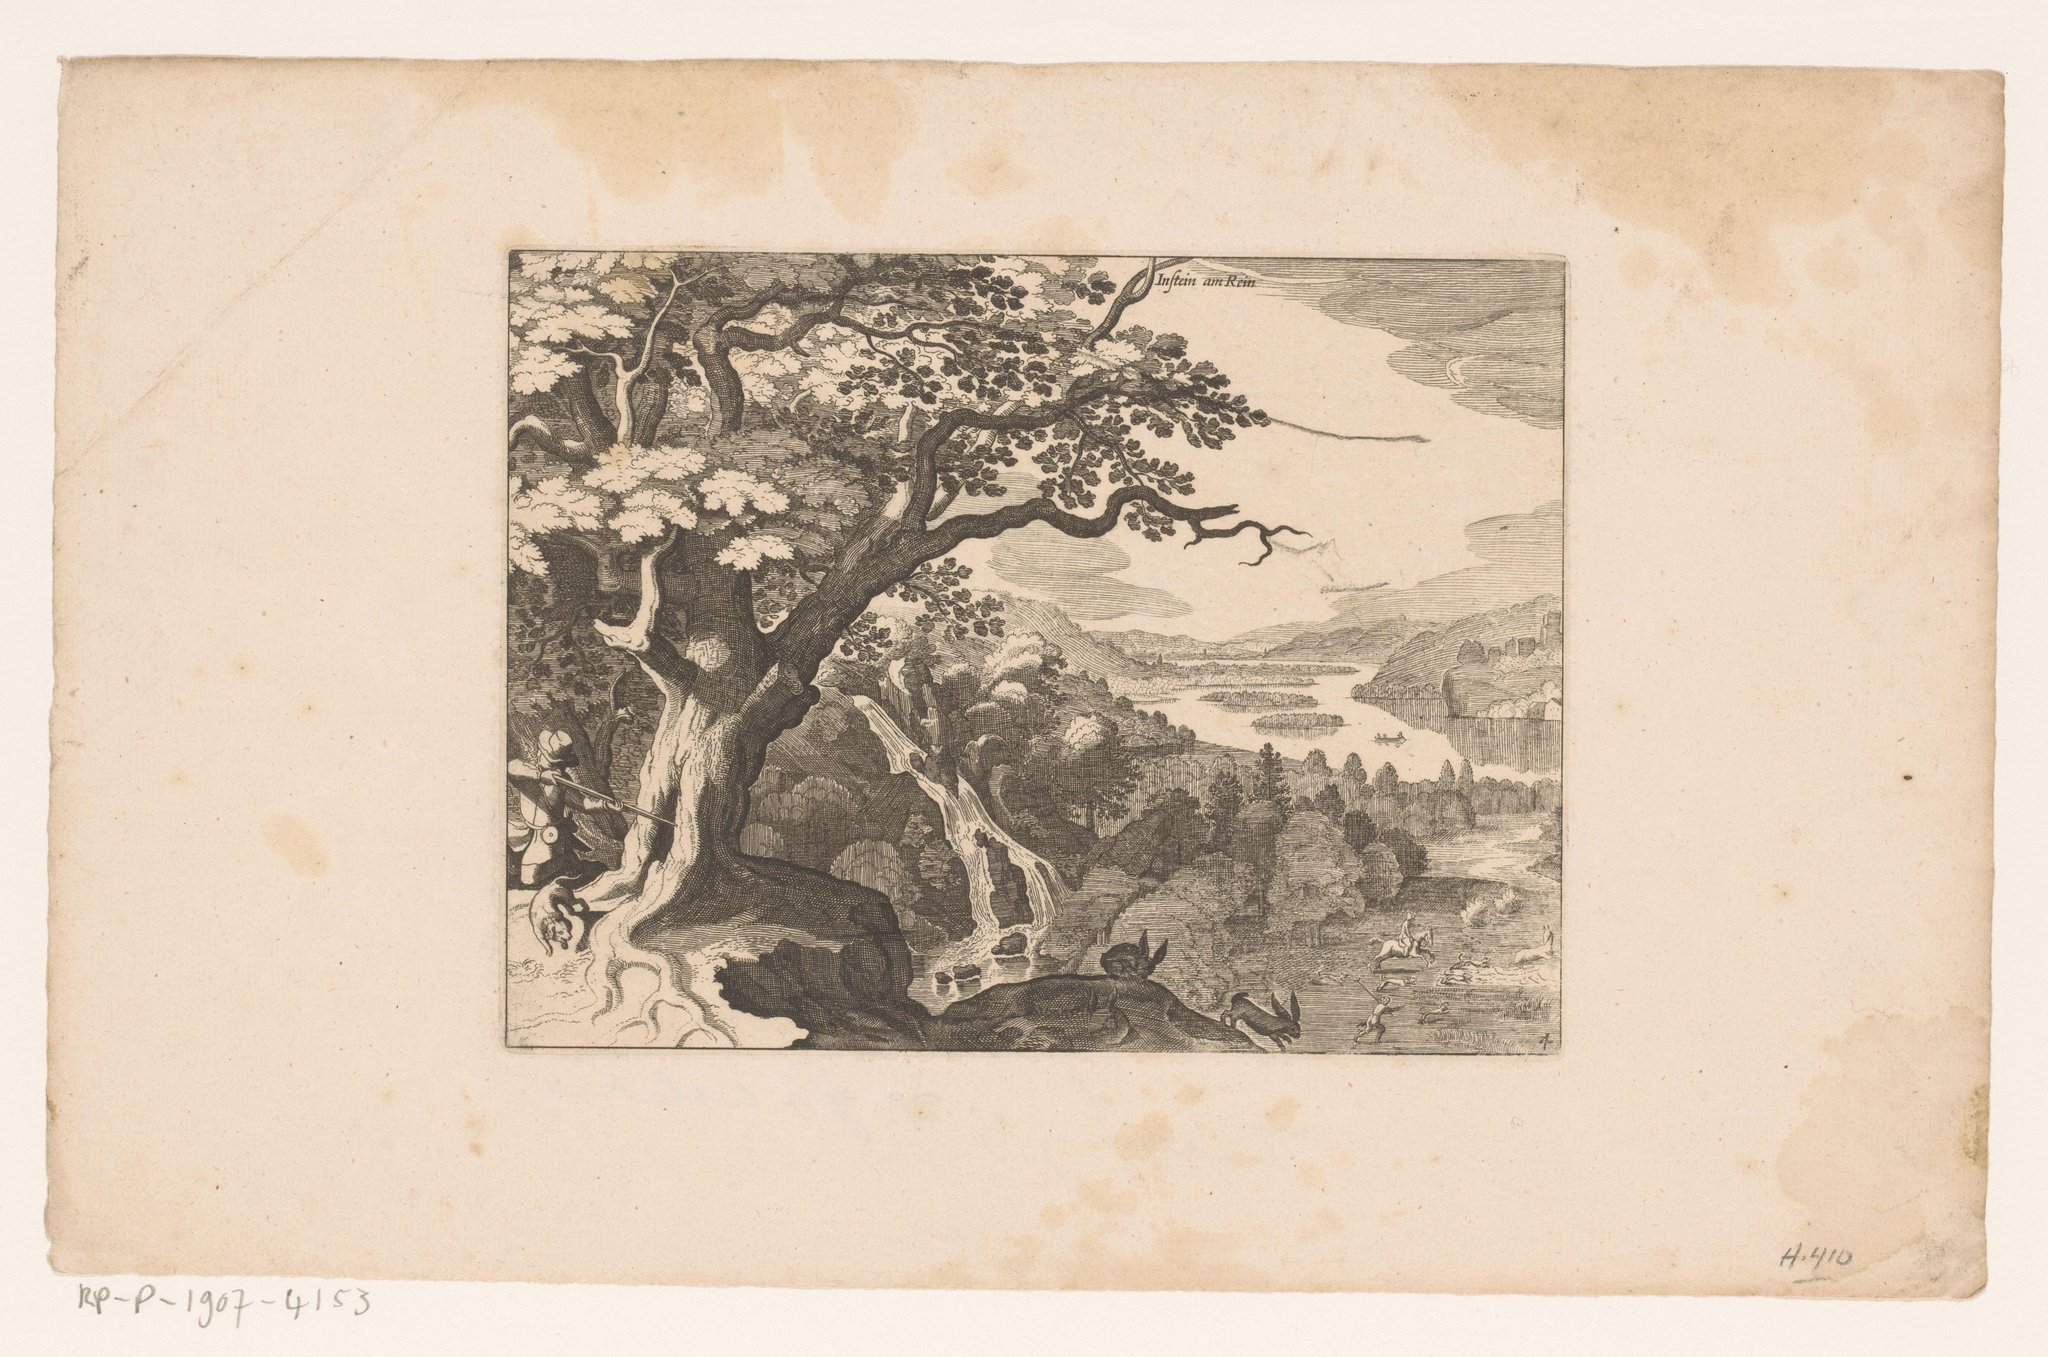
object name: print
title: Instein am Rein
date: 1628-1679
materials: paper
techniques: etching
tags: stag-hunting, hare-hunting, rabbit-hunting, river (+ landscape with figures, staffage), waterfall (+ landscape with figures, staffage)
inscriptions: collector's mark: Lugt 2228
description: Kopie in dezelfde richting naar de prent van Matthäus Merian I (Hollstein 343). Deze prent heeft nummer 3 rechtsonder gedrukt.